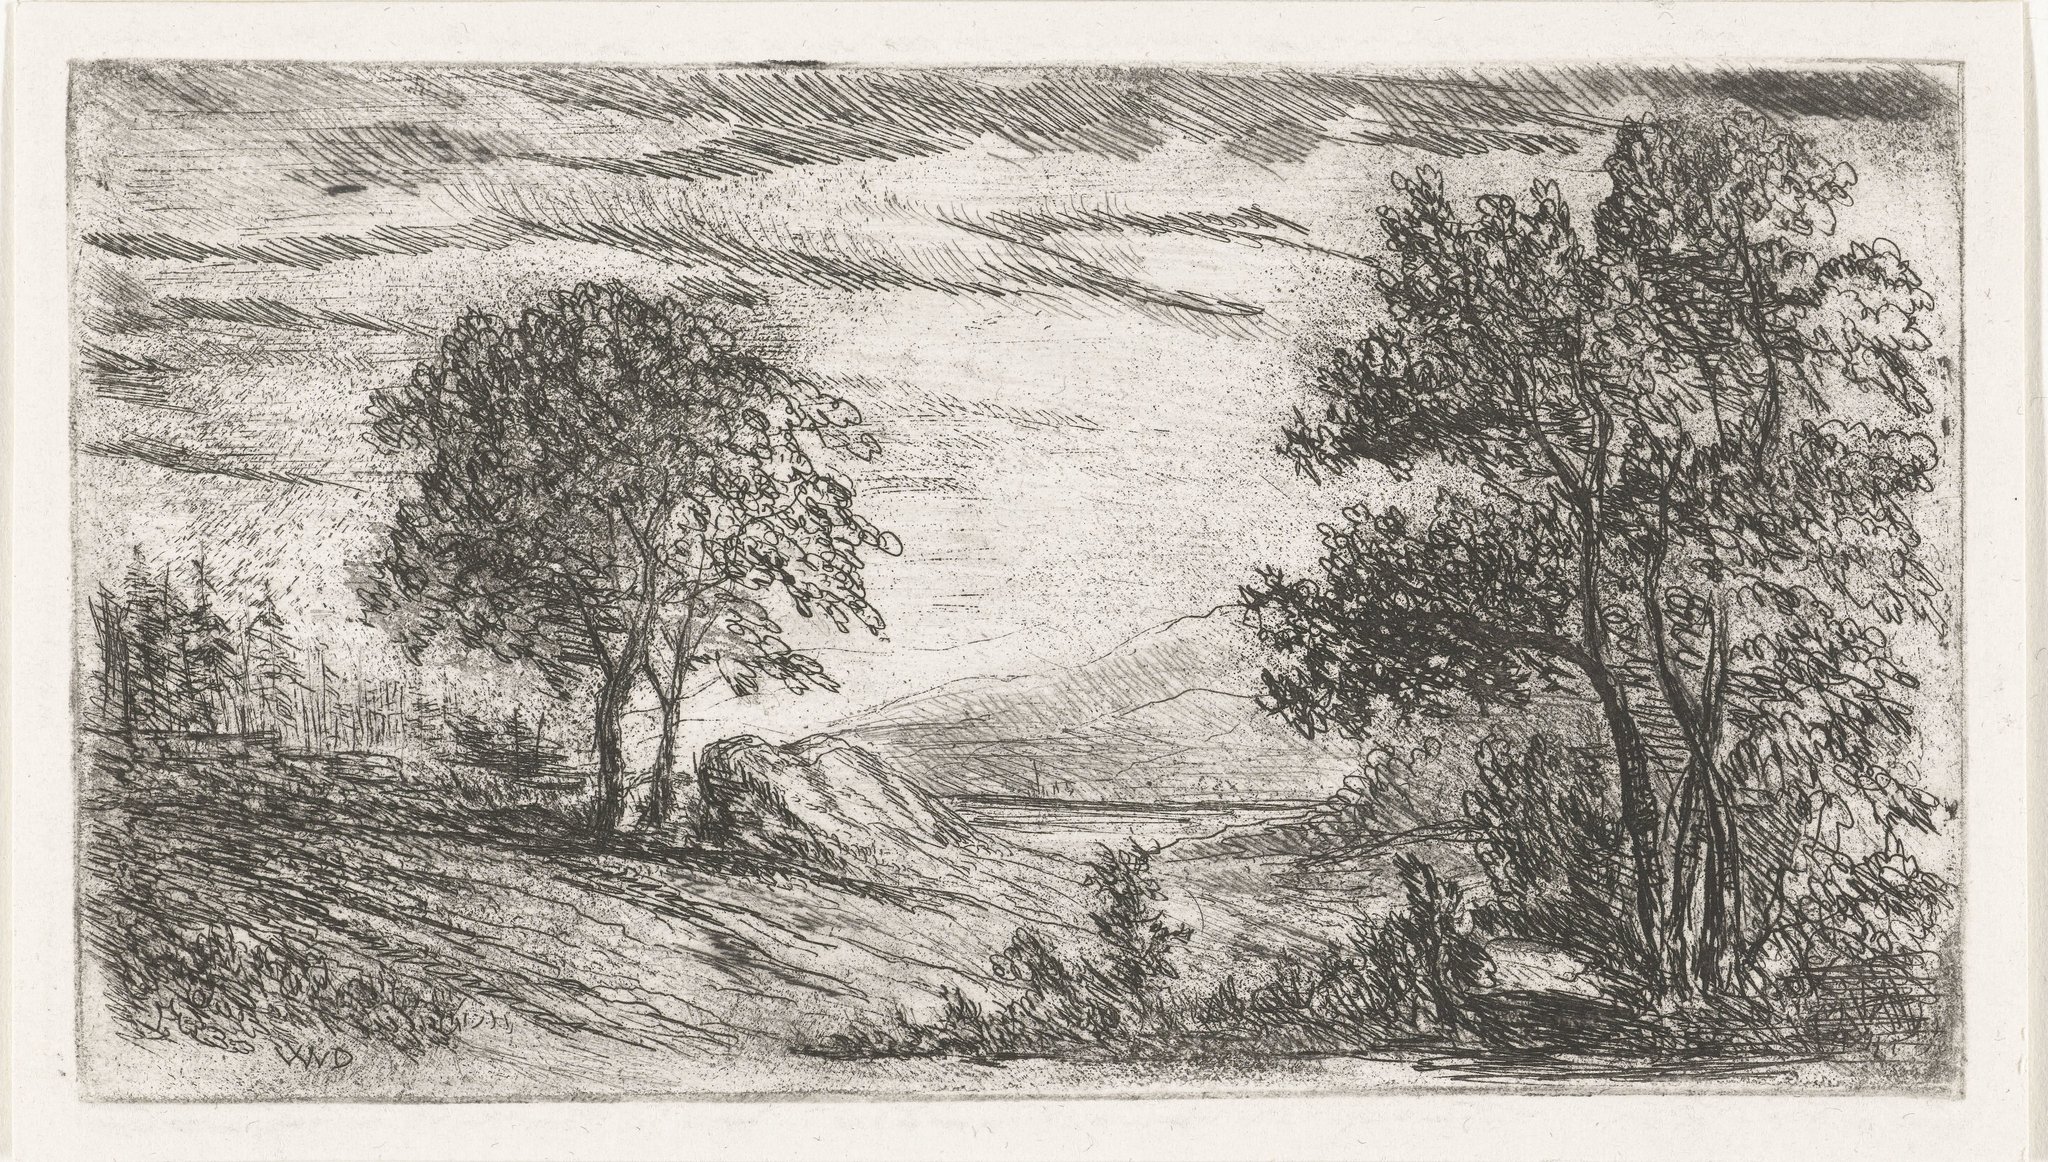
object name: print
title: Heuvellandschap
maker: willem matthias jan van dielen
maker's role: print maker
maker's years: 1805-1867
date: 1815-1867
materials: paper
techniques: etching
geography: netherlands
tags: low hill country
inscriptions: collector's mark: Lugt 2228